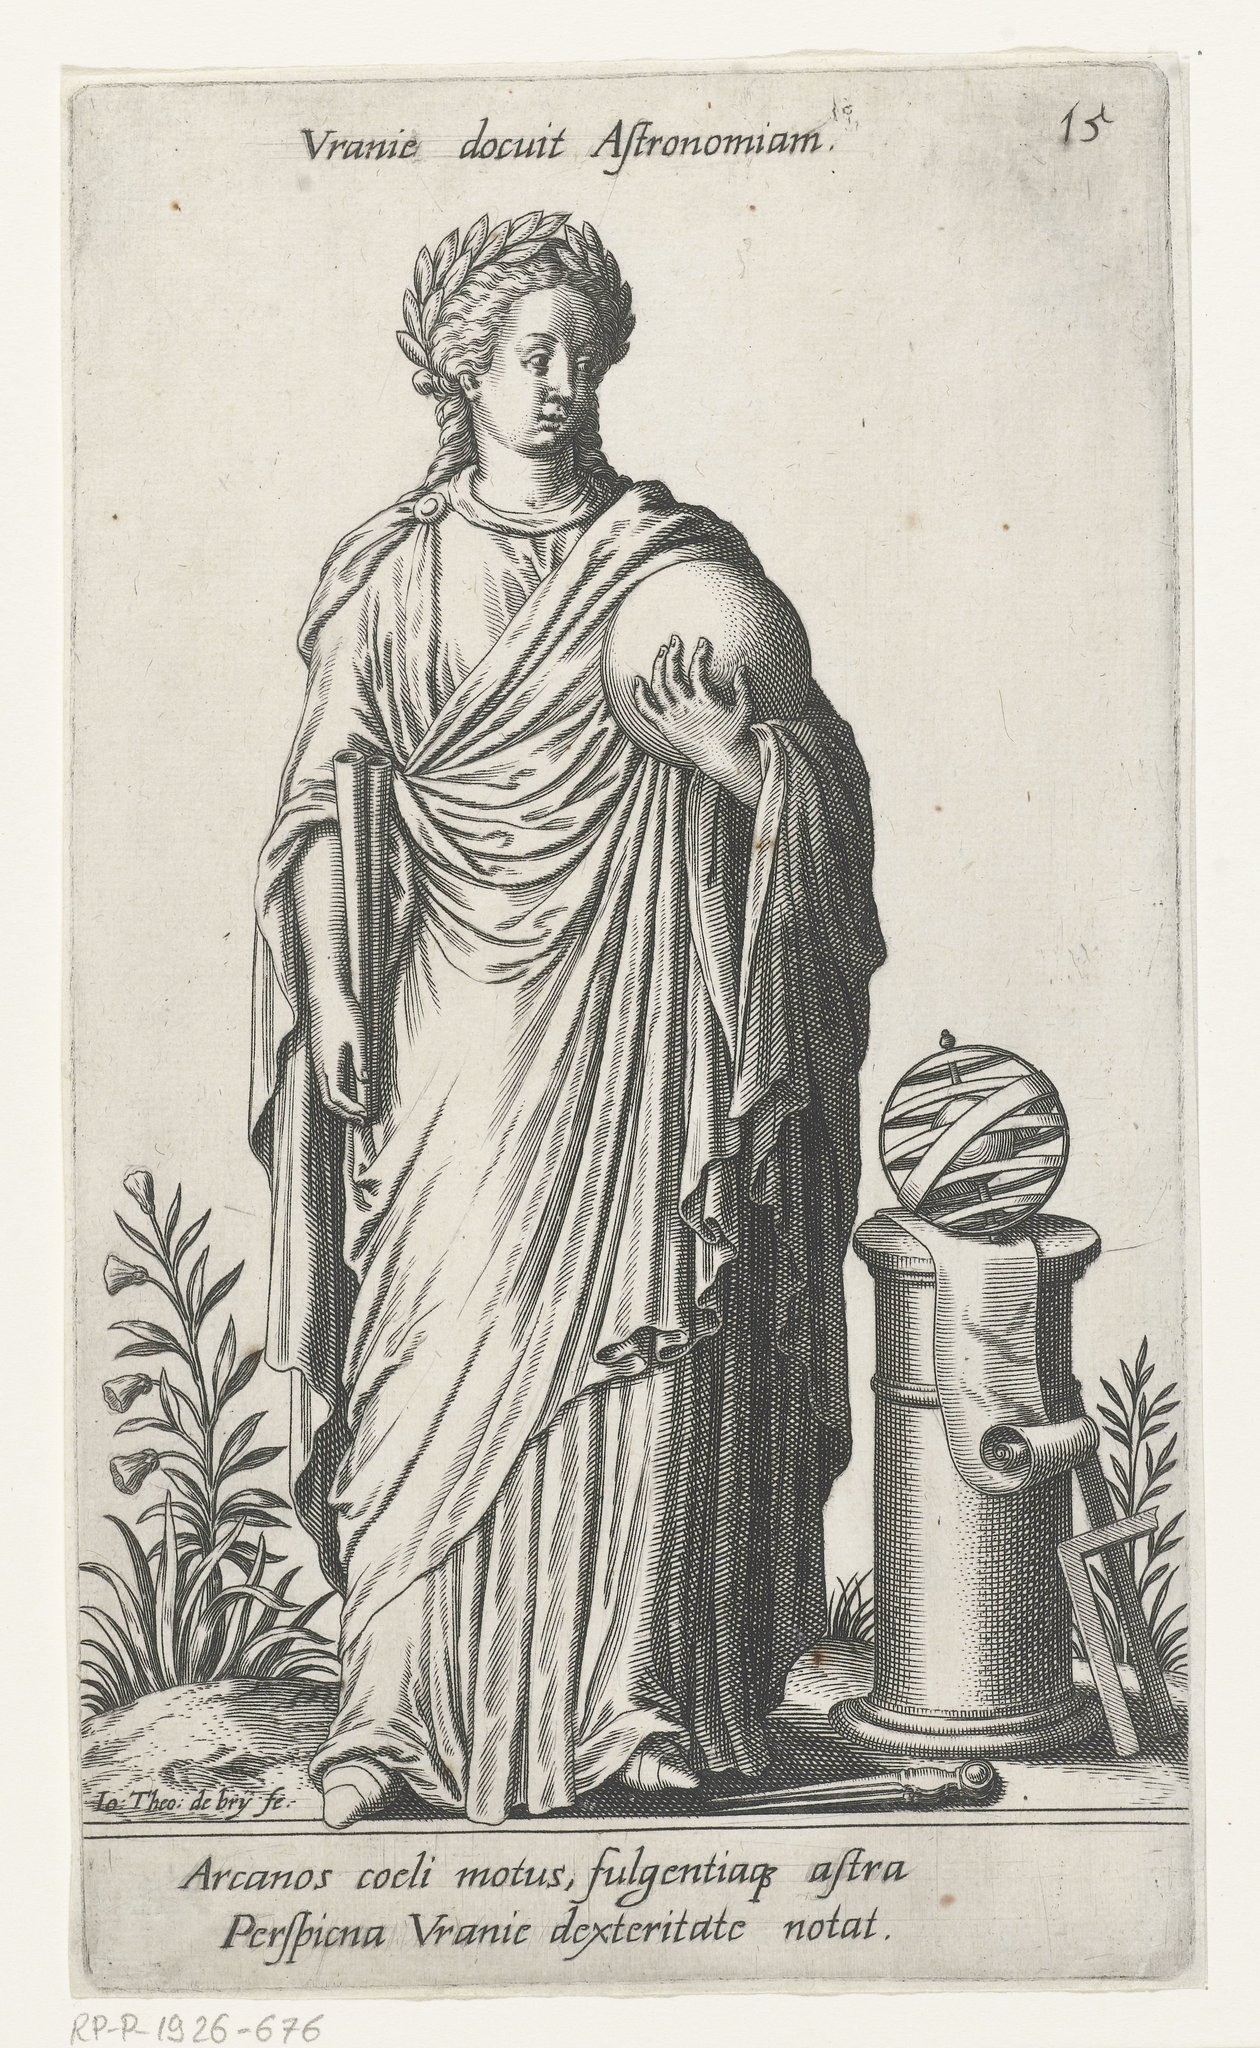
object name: print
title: Urania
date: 1601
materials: paper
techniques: engraving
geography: germany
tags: urania (one of the muses); 'urania' (ripa)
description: De muze van de astronomie Urania met een bol in haar arm en een papieren rol in haar hand. Naast haar staat een pilaar met een astrolab en andere meetinstrumenten. Uit: Parnassus cum imaginibus Musarum Deorumq[ue] praesidum Hippocrenes.